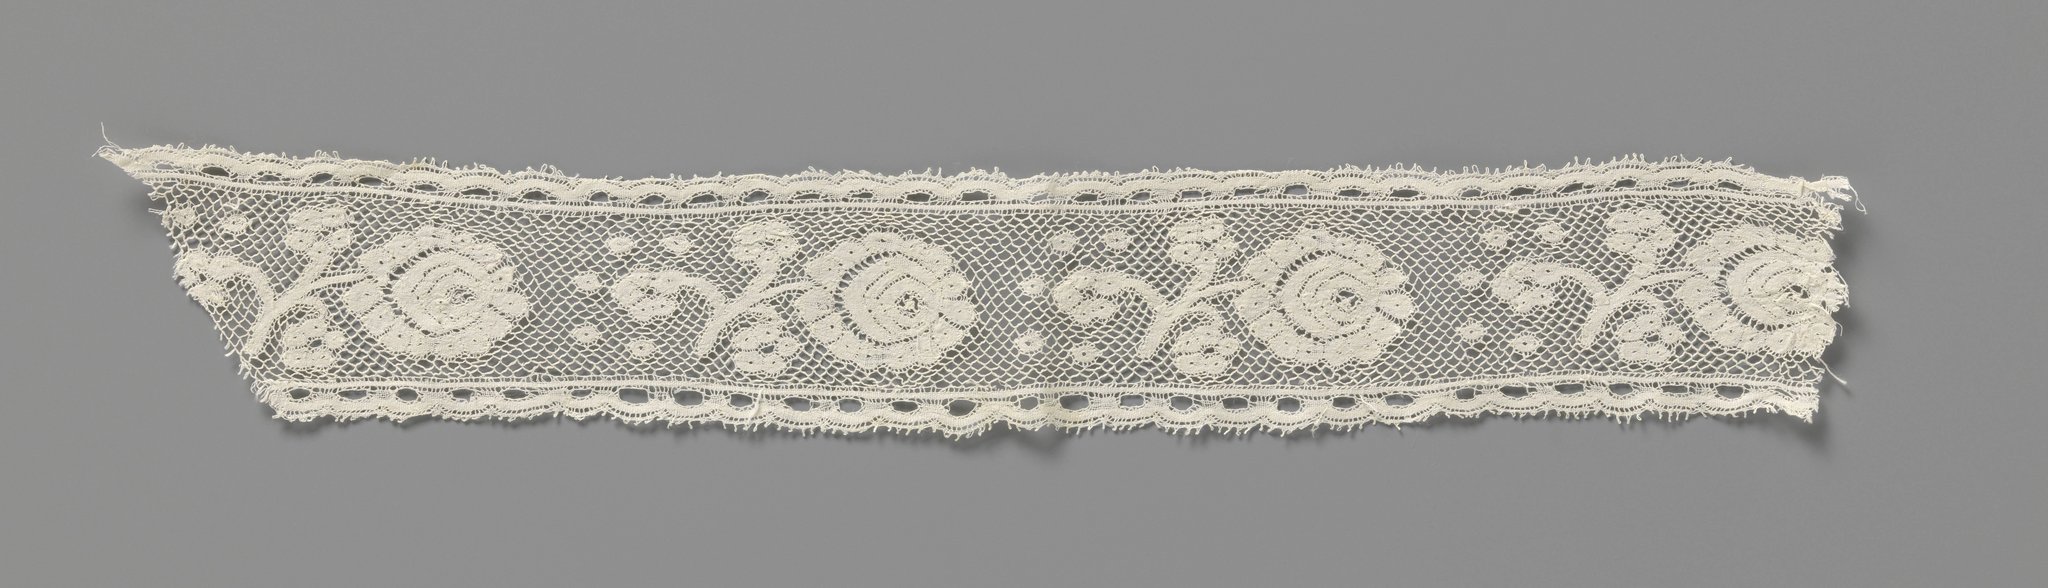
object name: strip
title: Tussenzetsel van kloskant met roosjes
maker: Anonymous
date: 1890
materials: linen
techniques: lace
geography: ieper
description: Tussen twee boogjesrandjes, met openingen voor een lintje, loopt een baan met vierkante mazen, waarop een rij roosjes aan kromme takjes staan. Valenciennes-kant.